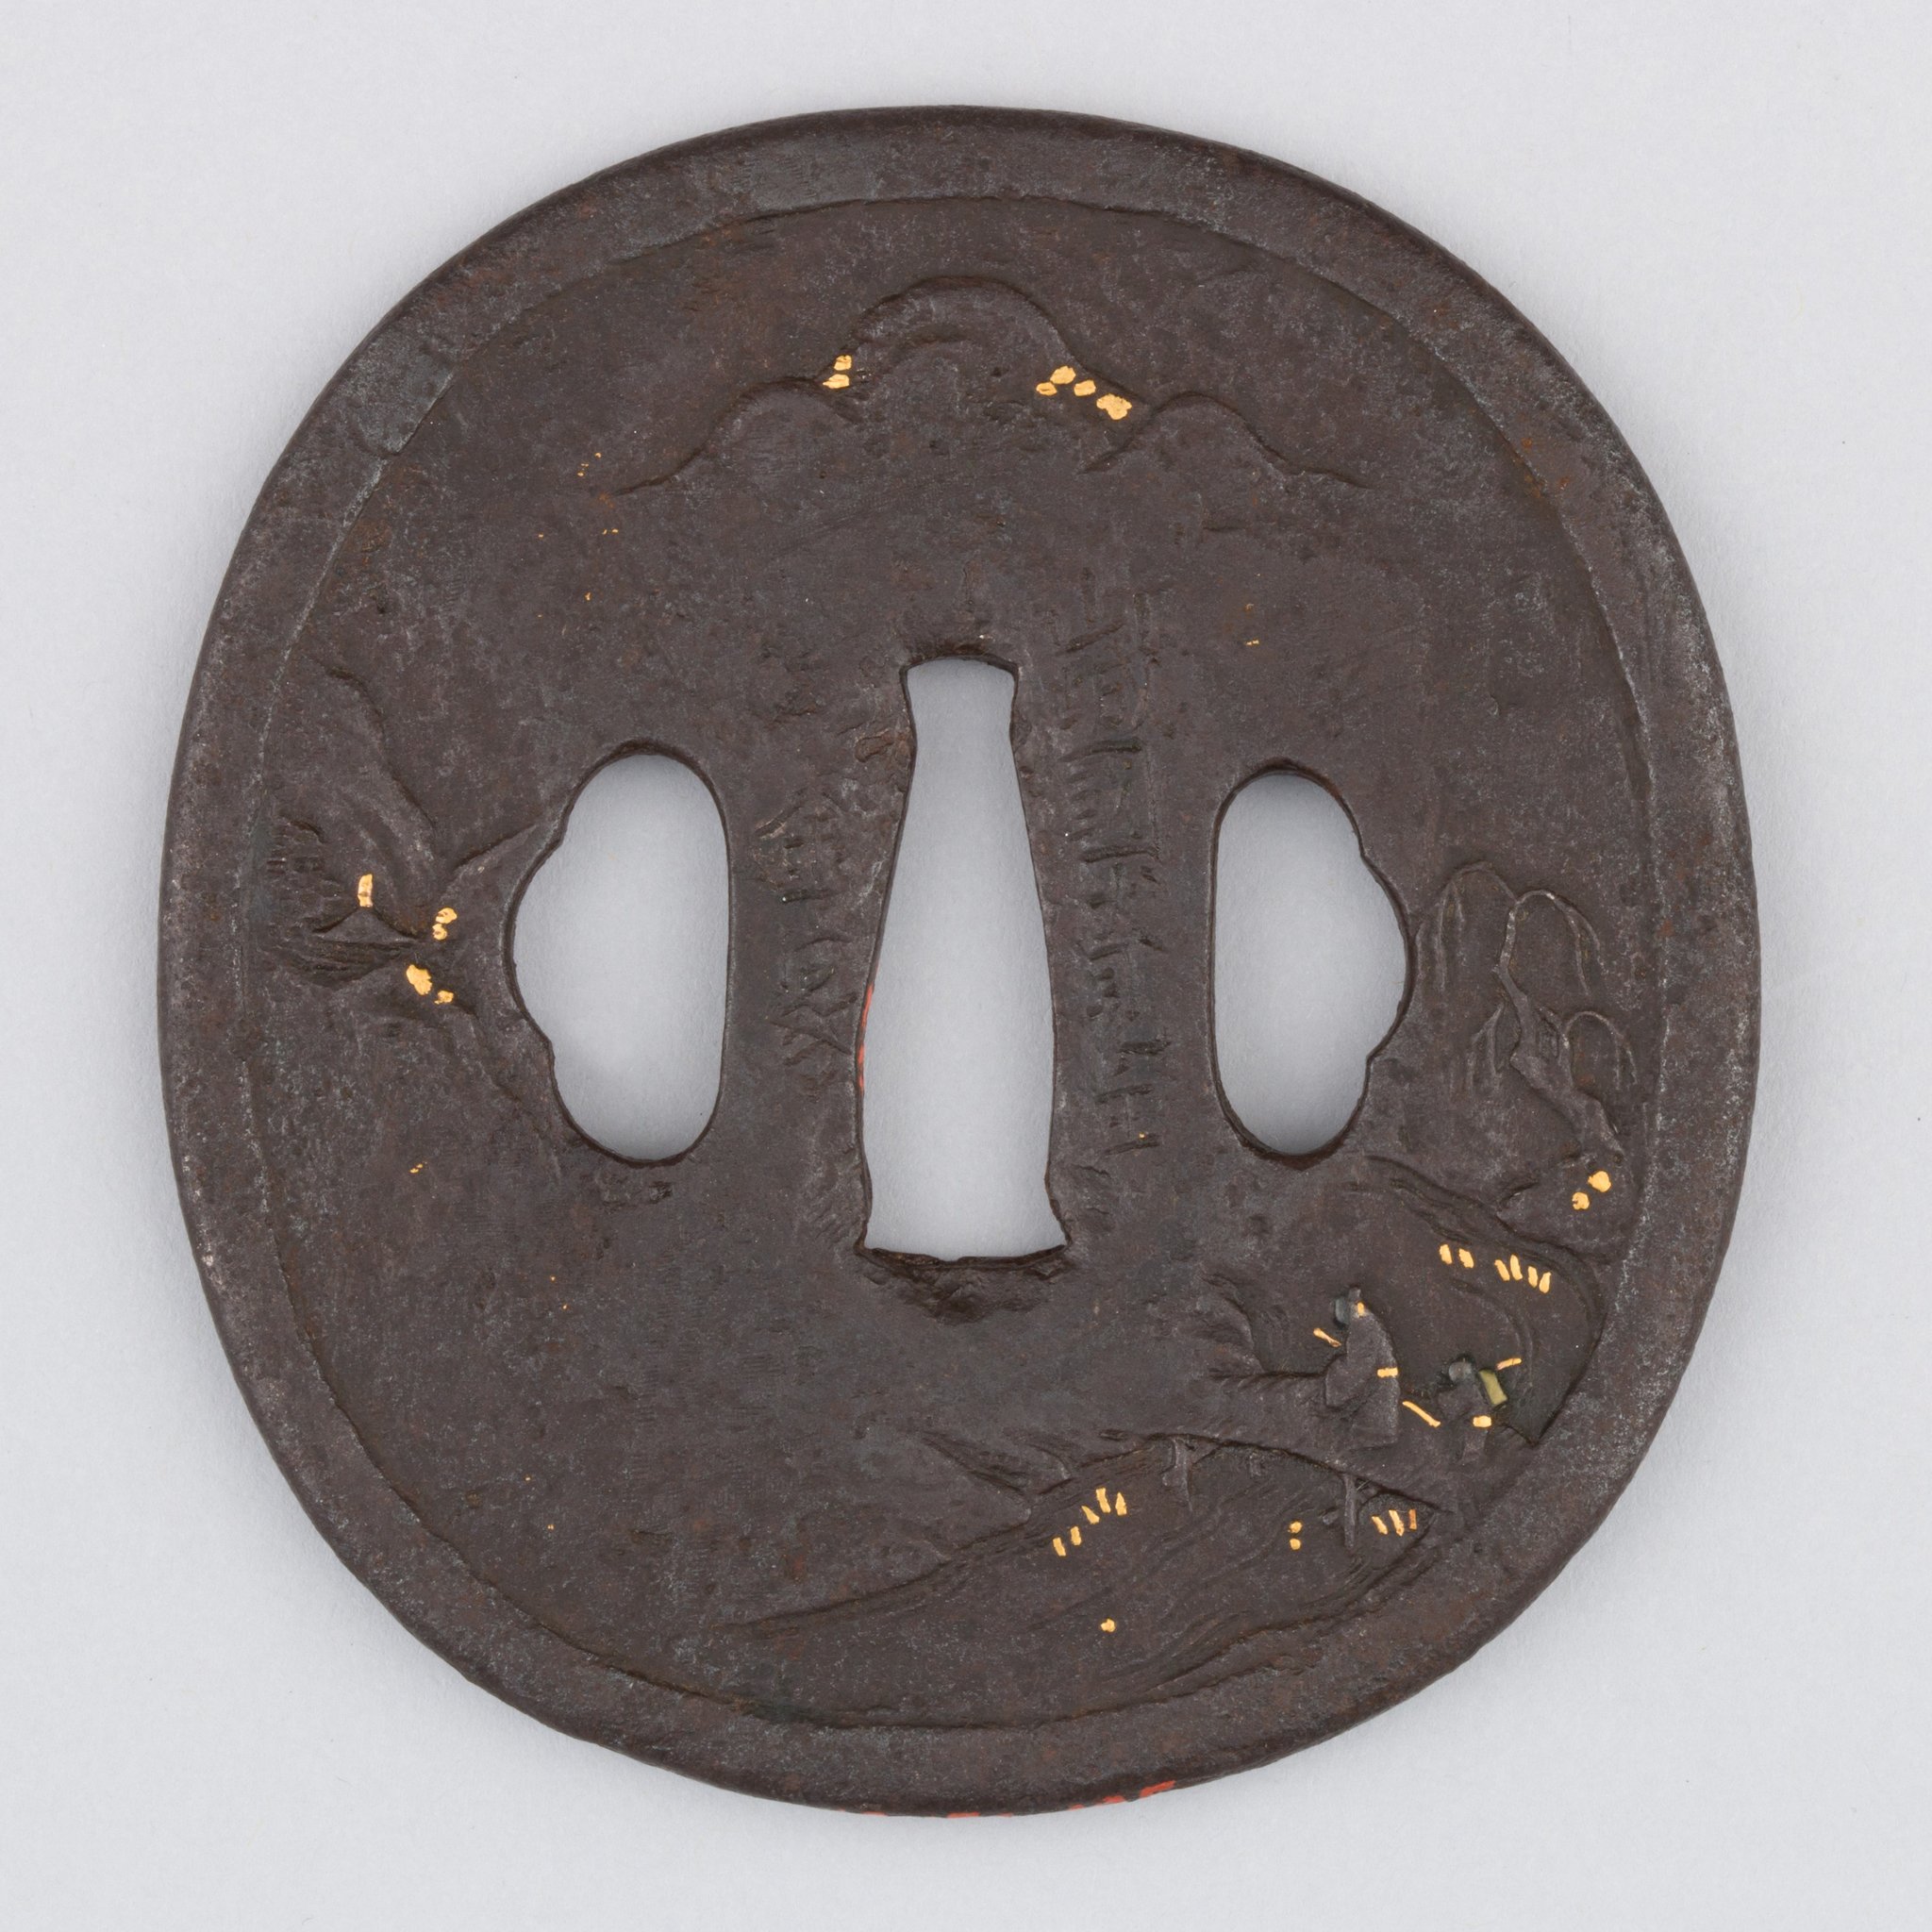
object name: sword guard tsuba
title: Sword Guard (Tsuba)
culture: japanese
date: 1615-1868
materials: copper, iron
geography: japan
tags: men